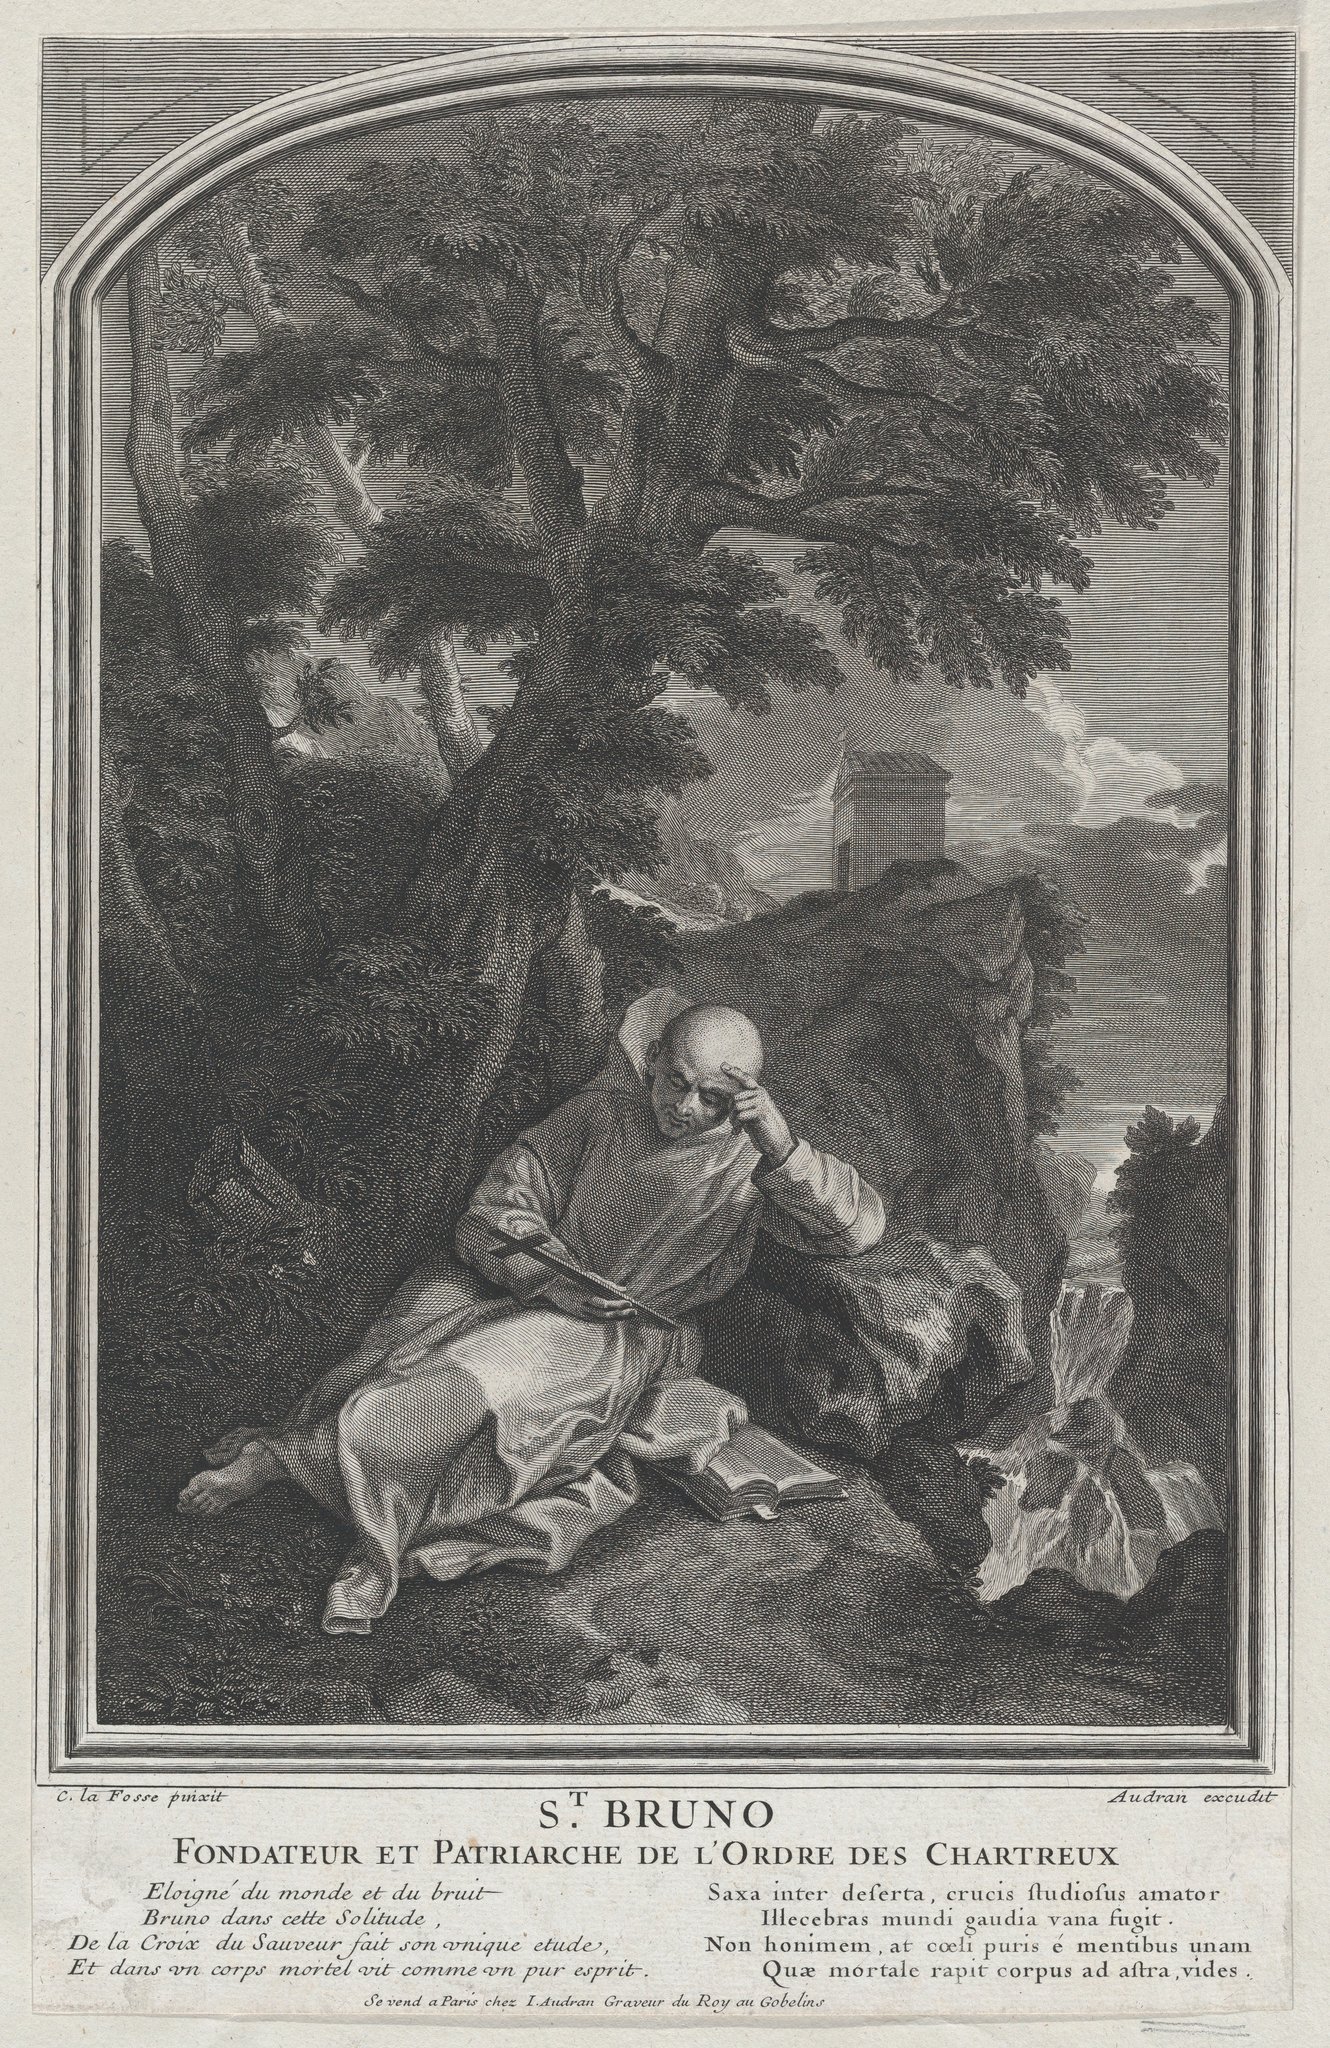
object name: print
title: St. Bruno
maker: jean audran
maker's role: artist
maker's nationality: french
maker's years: 1667-1756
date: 1701-1800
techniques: engraving, etching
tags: men,cross,saints